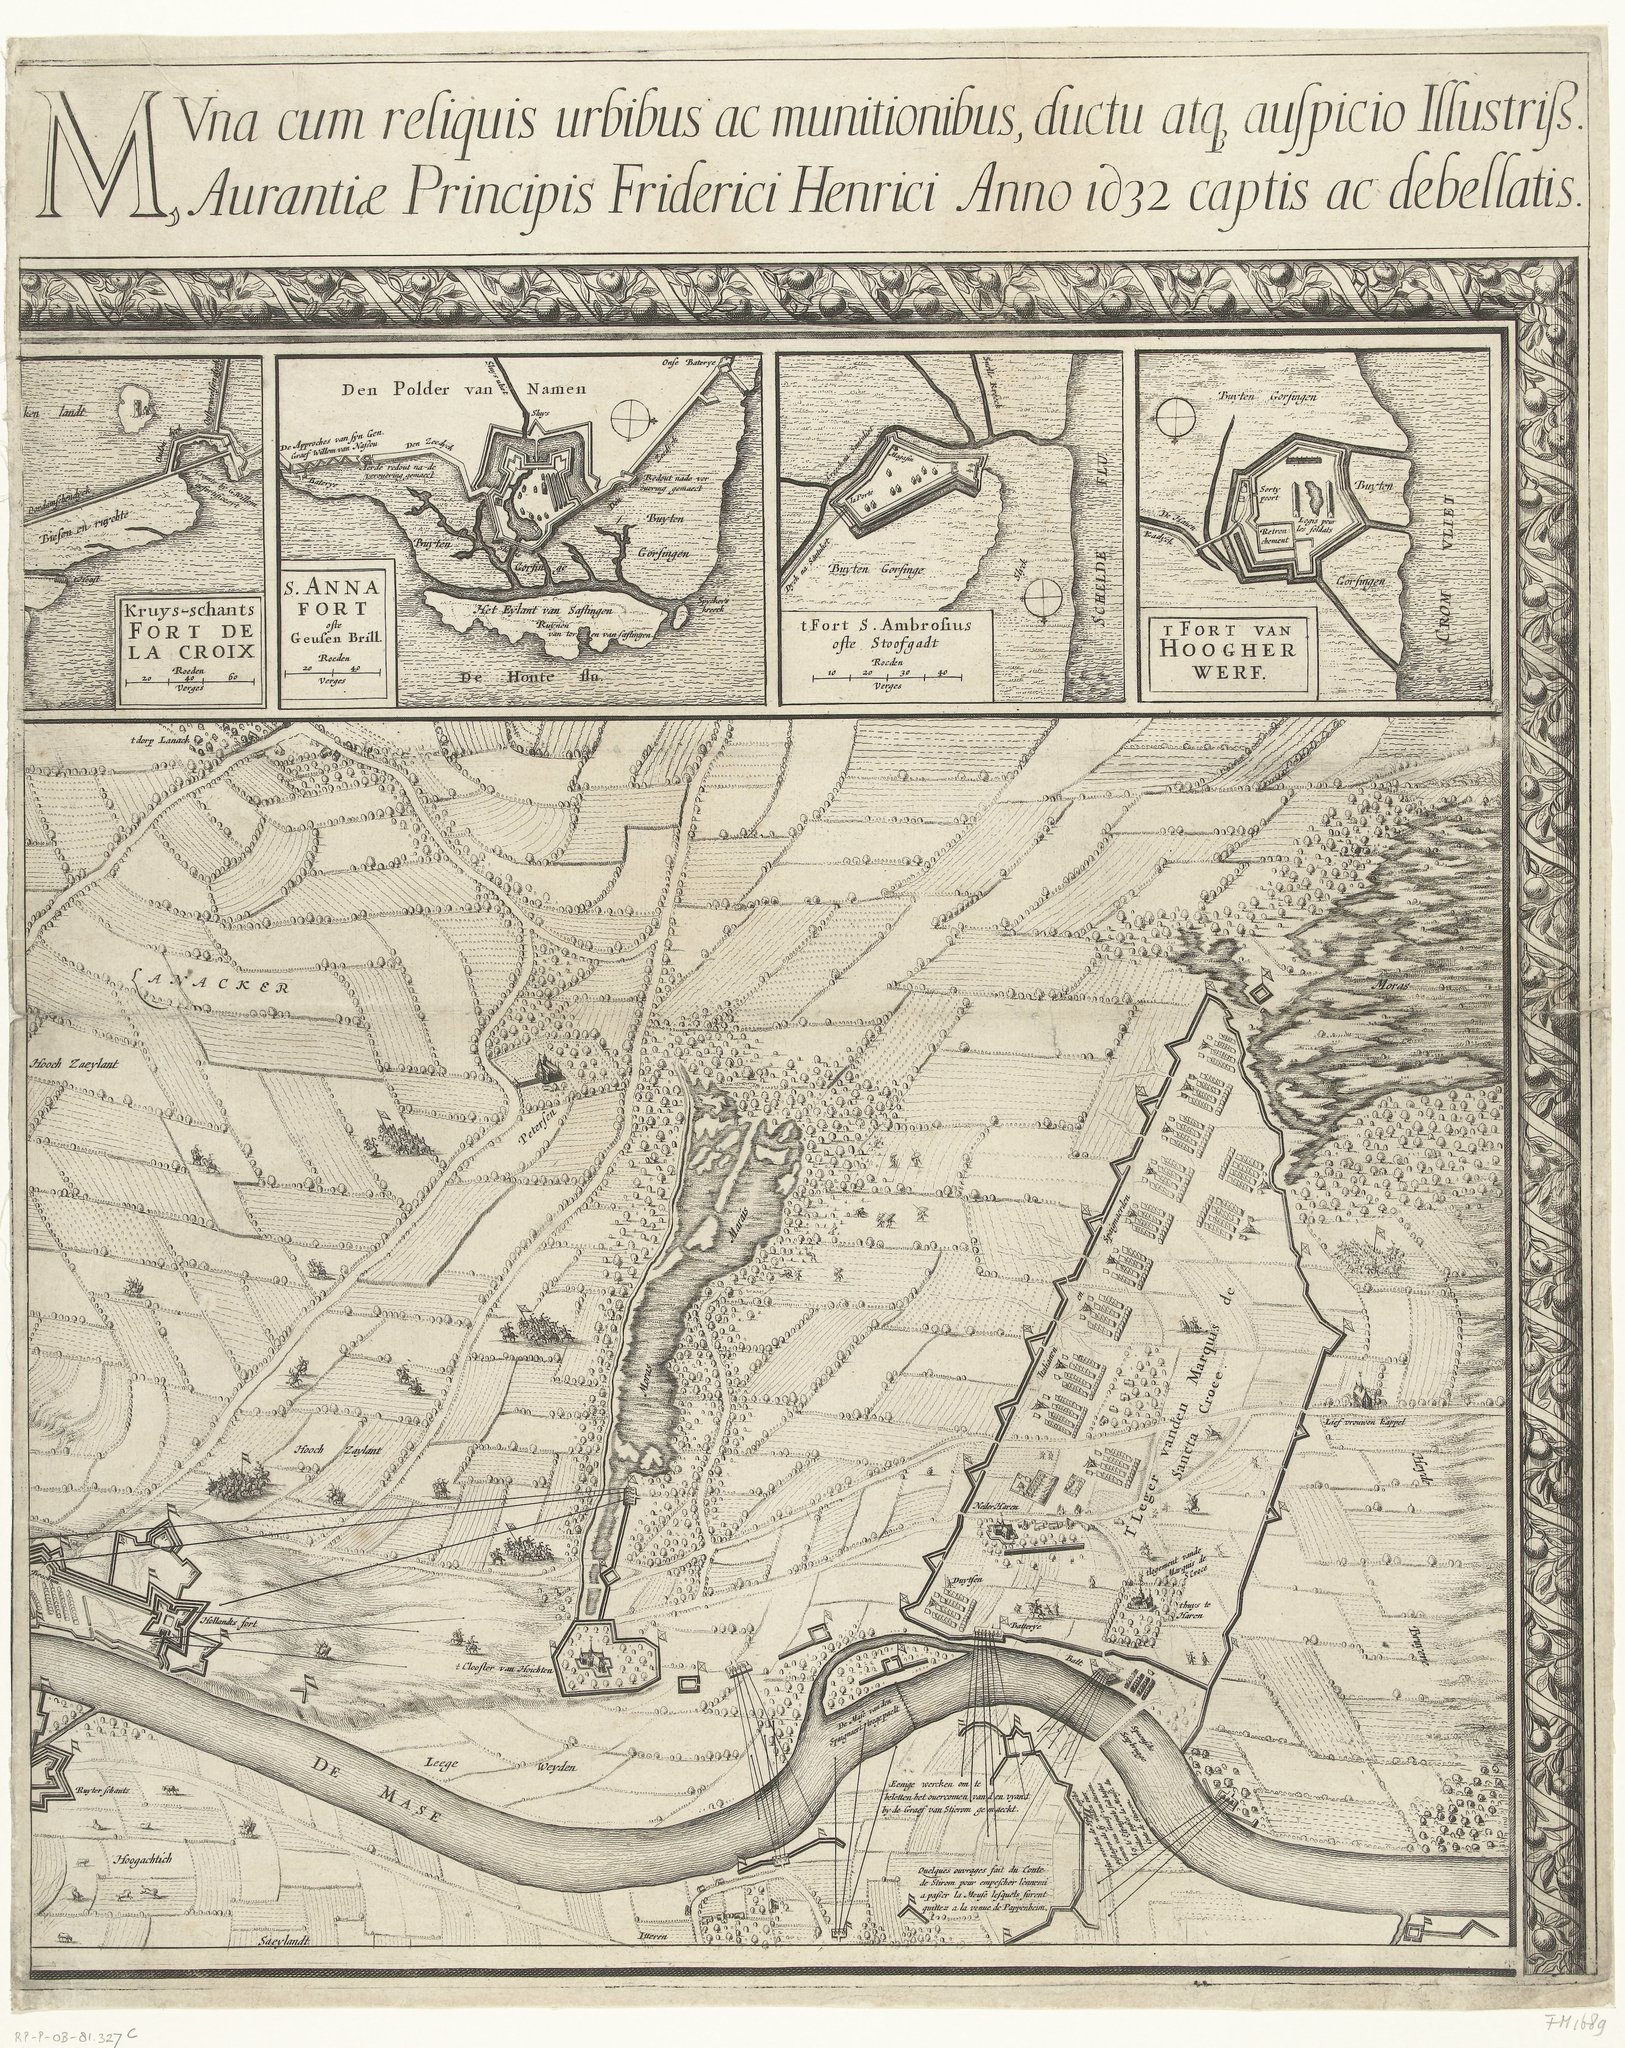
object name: map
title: Expugnatio Trajecti ad Mosam, Una cum reliquis urbibus ac munitionibus, ductuatq. auspico Illustriss. Aurantiae Principis Friderici Henrici Anno 1632 captis ac debellatis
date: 1632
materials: paper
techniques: etching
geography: northern netherlands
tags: delft, frederick henry (prince of orange), maps of separate countries or regions, siege, position war, maastricht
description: Grote kaart van het beleg en de inname van Maastricht door het Staatse leger onder stadhouder Frederik Hendrik, 9 juni tot 21 augustus 1632. Kaart samengesteld uit zes bladen, drie boven en drie beneden (het zesde blad rechtsonder ontbreekt). Dit is het blad rechtsboven. Rechts het legerkamp van de troepen van markies de Sancta Croce die ter ontzetting van de stad waren gekomen. Bovenaan inzetten met kaartjes van verschillende forten. Met opschriften in de voorstelling in het Frans en Nederlands.